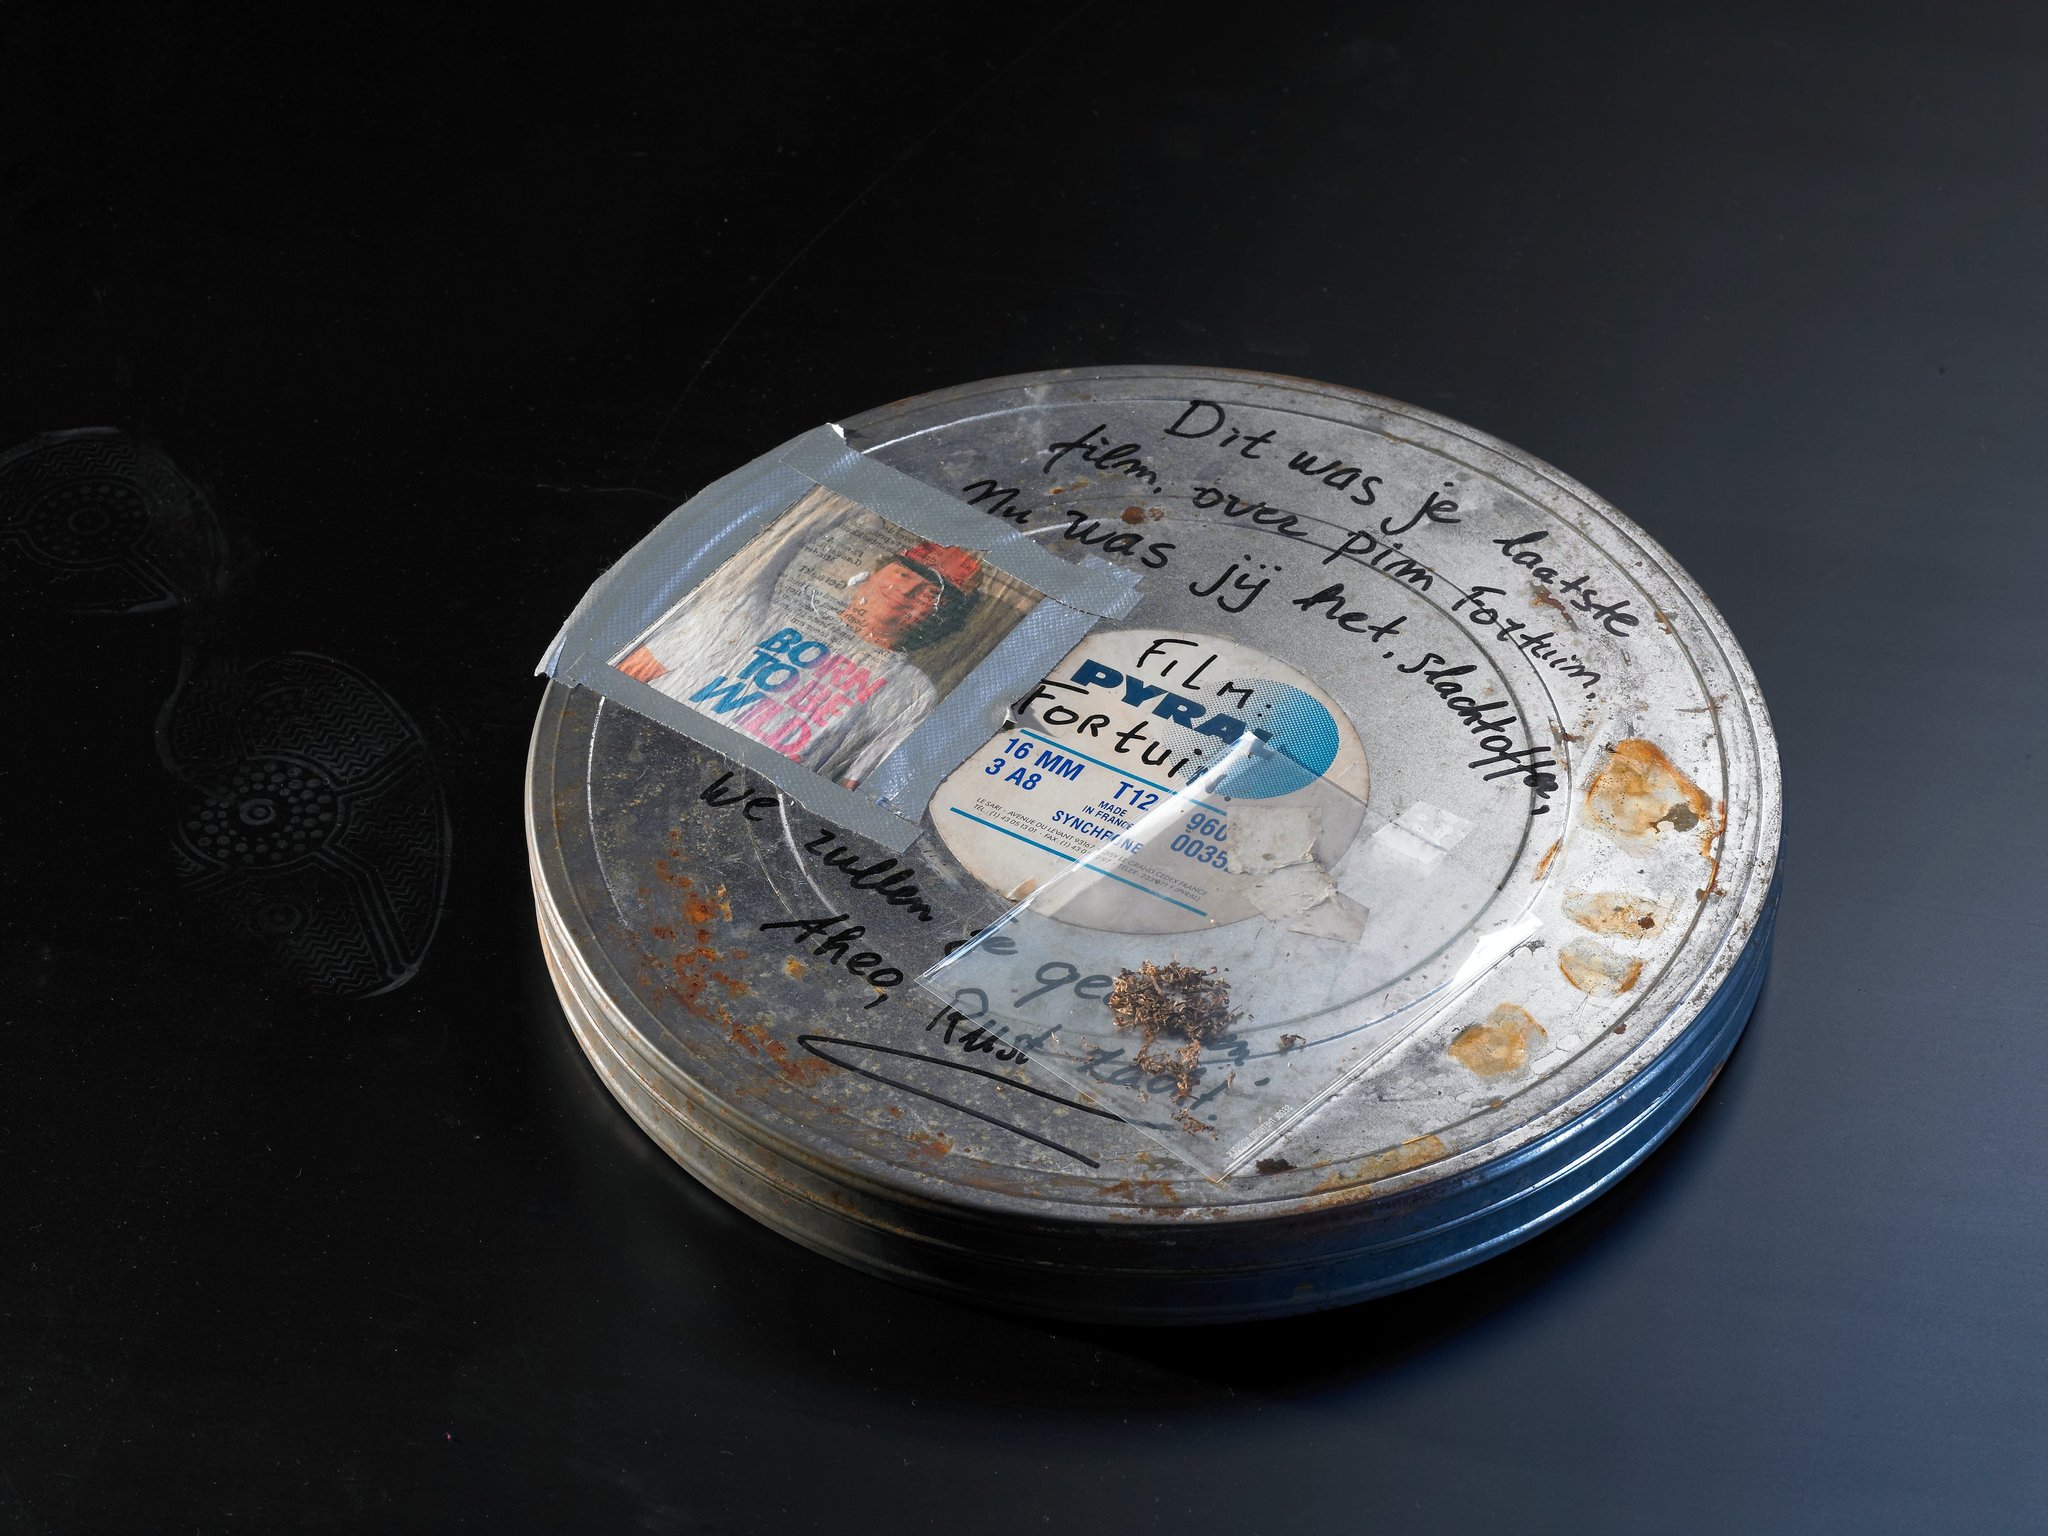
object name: film can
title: Filmblik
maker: Anonymous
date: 2004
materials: metal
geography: amsterdam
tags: politician, theo van gogh, amsterdam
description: Metalen filmblik met opschrift: Dit was je laatste film over Pim Fortuin. Nu was jij het slachtoffer. We zullen je gedenken. Theo, rust zacht. Op het etiket van het blik staat: Film Fortuin. Er zit een sigarettenpeuk opgeplakt en een knipsel met een foto van Theo van Gogh - Born to be wild.